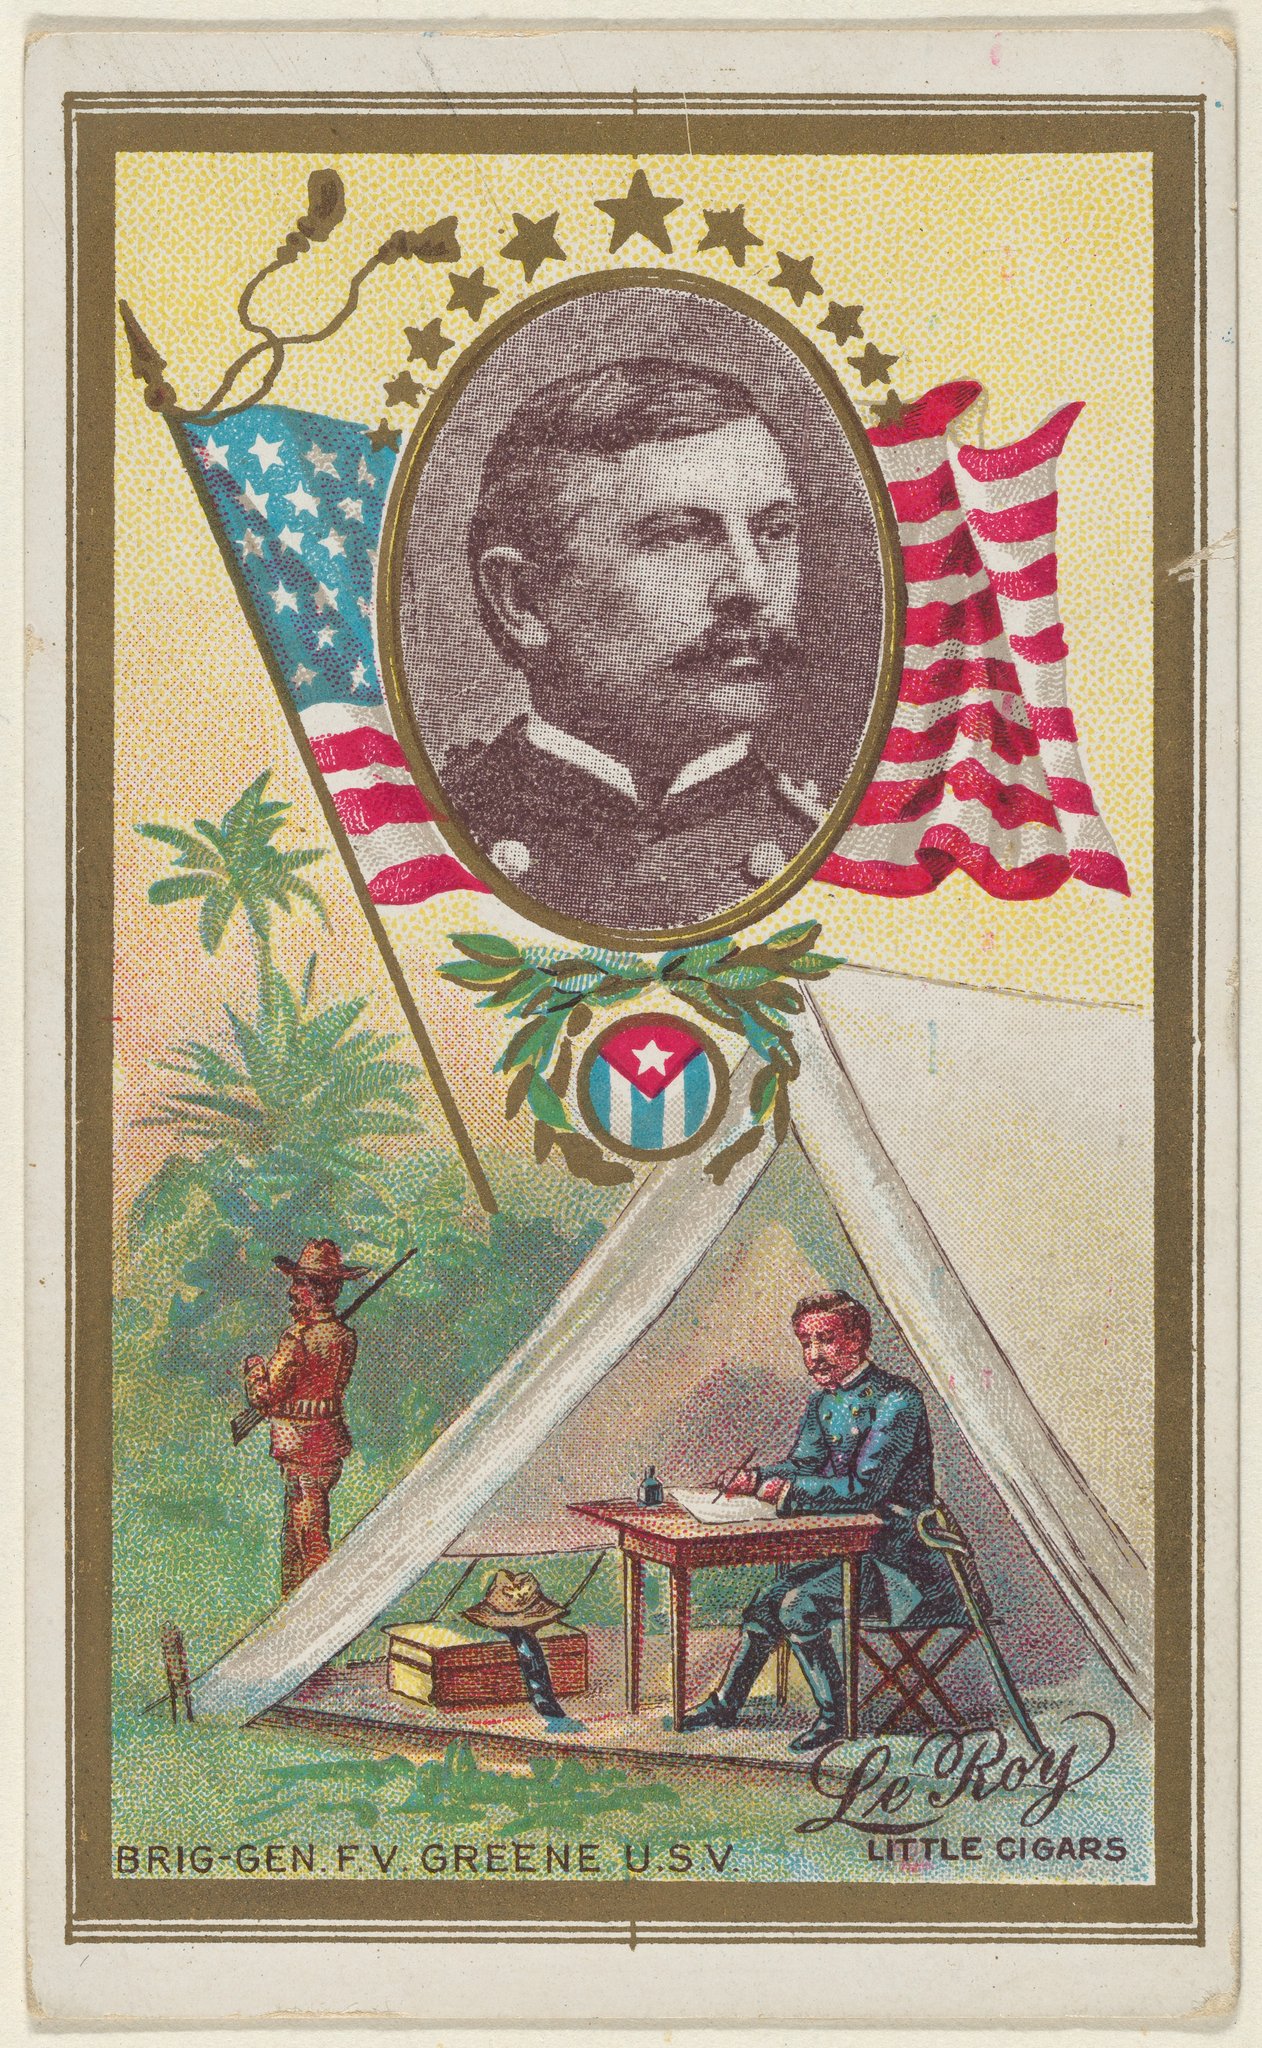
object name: print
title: Brigadier General Francis V. Greene, U.S. Volunteers, from the "Generals" series (T63), issued by LeRoy Little Cigars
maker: leroy little cigars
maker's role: publisher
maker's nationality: american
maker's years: 1850-1950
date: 1898-1901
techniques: color lithograph